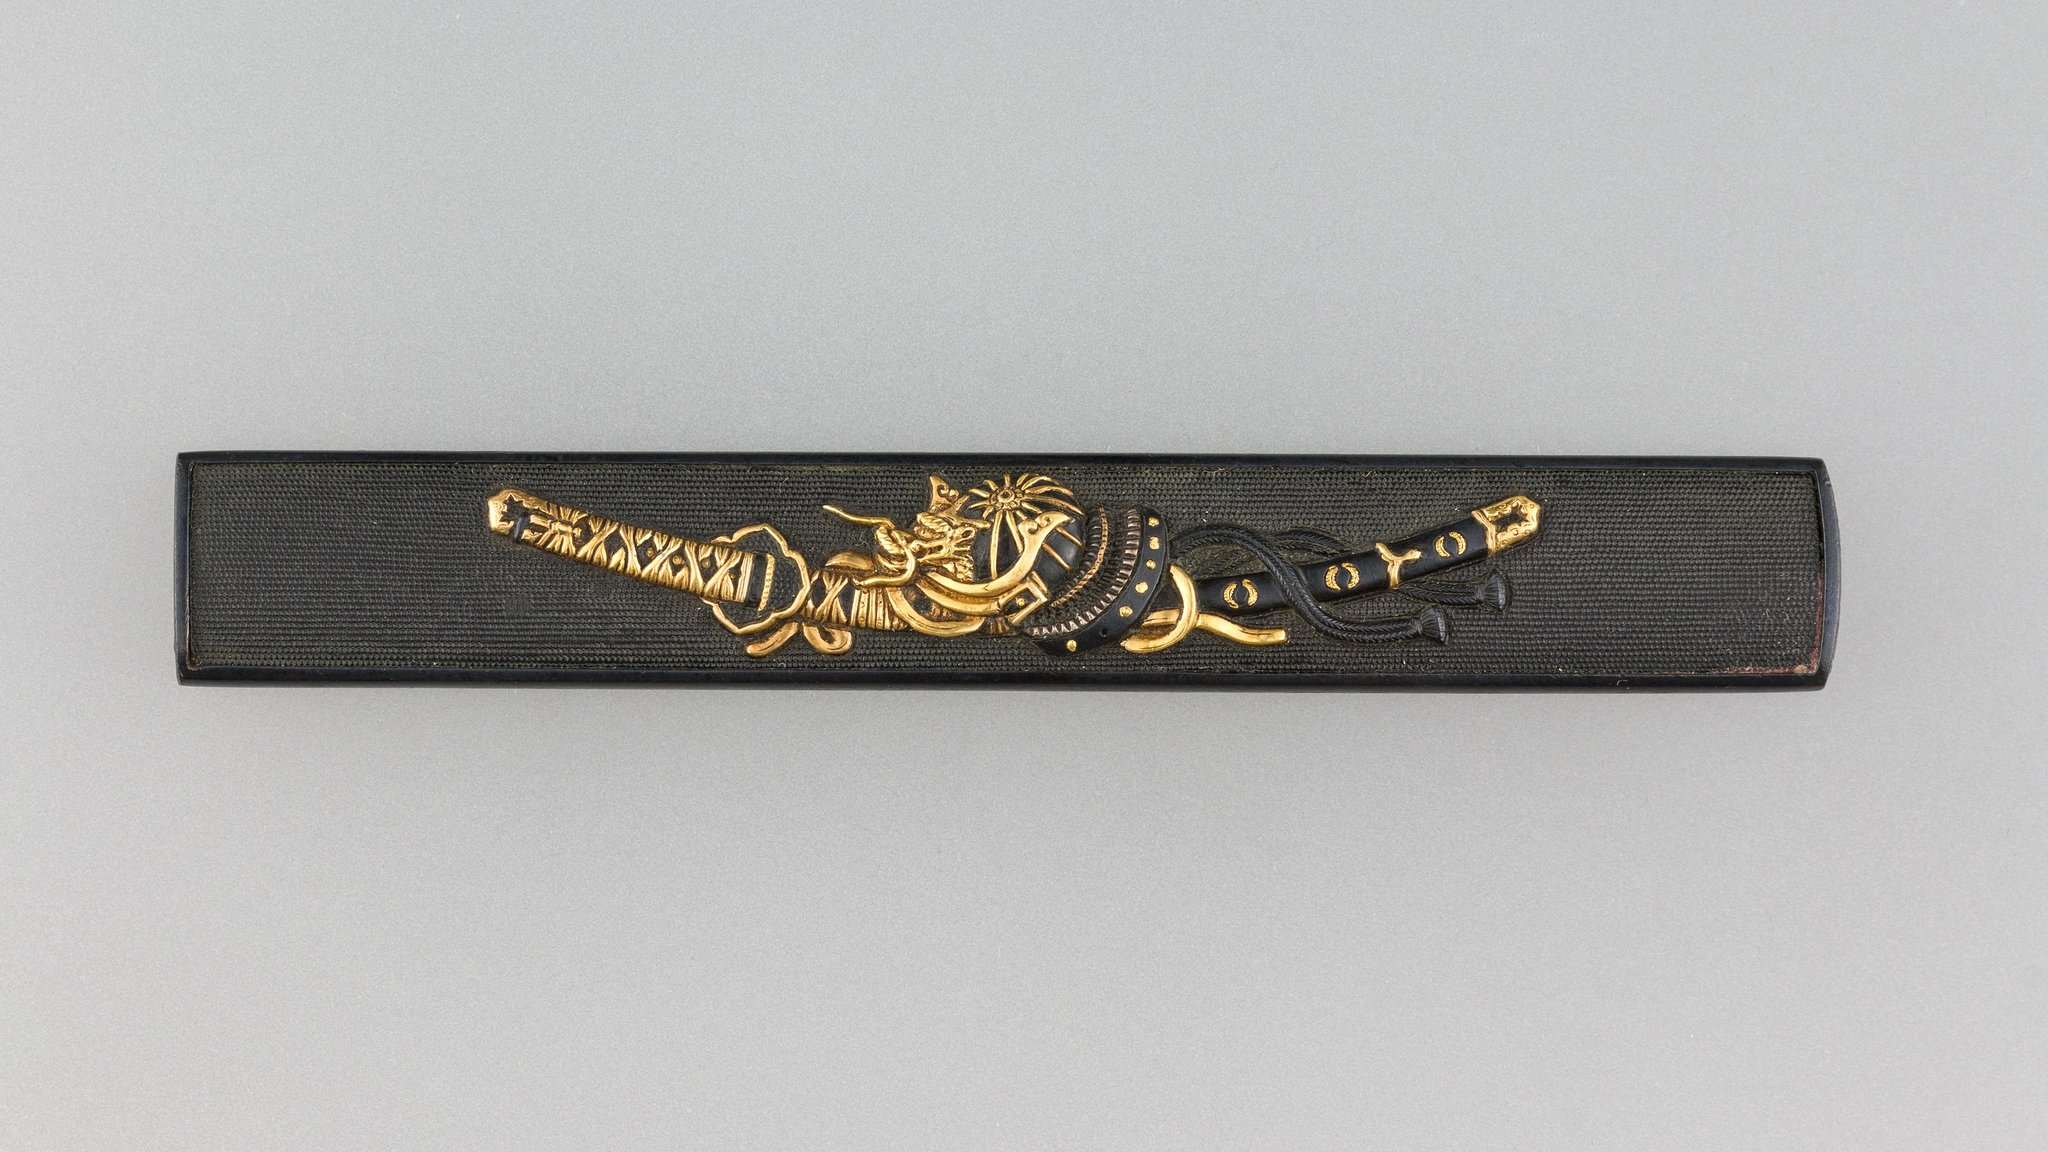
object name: knife handle kozuka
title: Knife Handle (Kozuka)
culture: japanese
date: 1651-1700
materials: gold alloy, gold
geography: japan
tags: swords,dragons